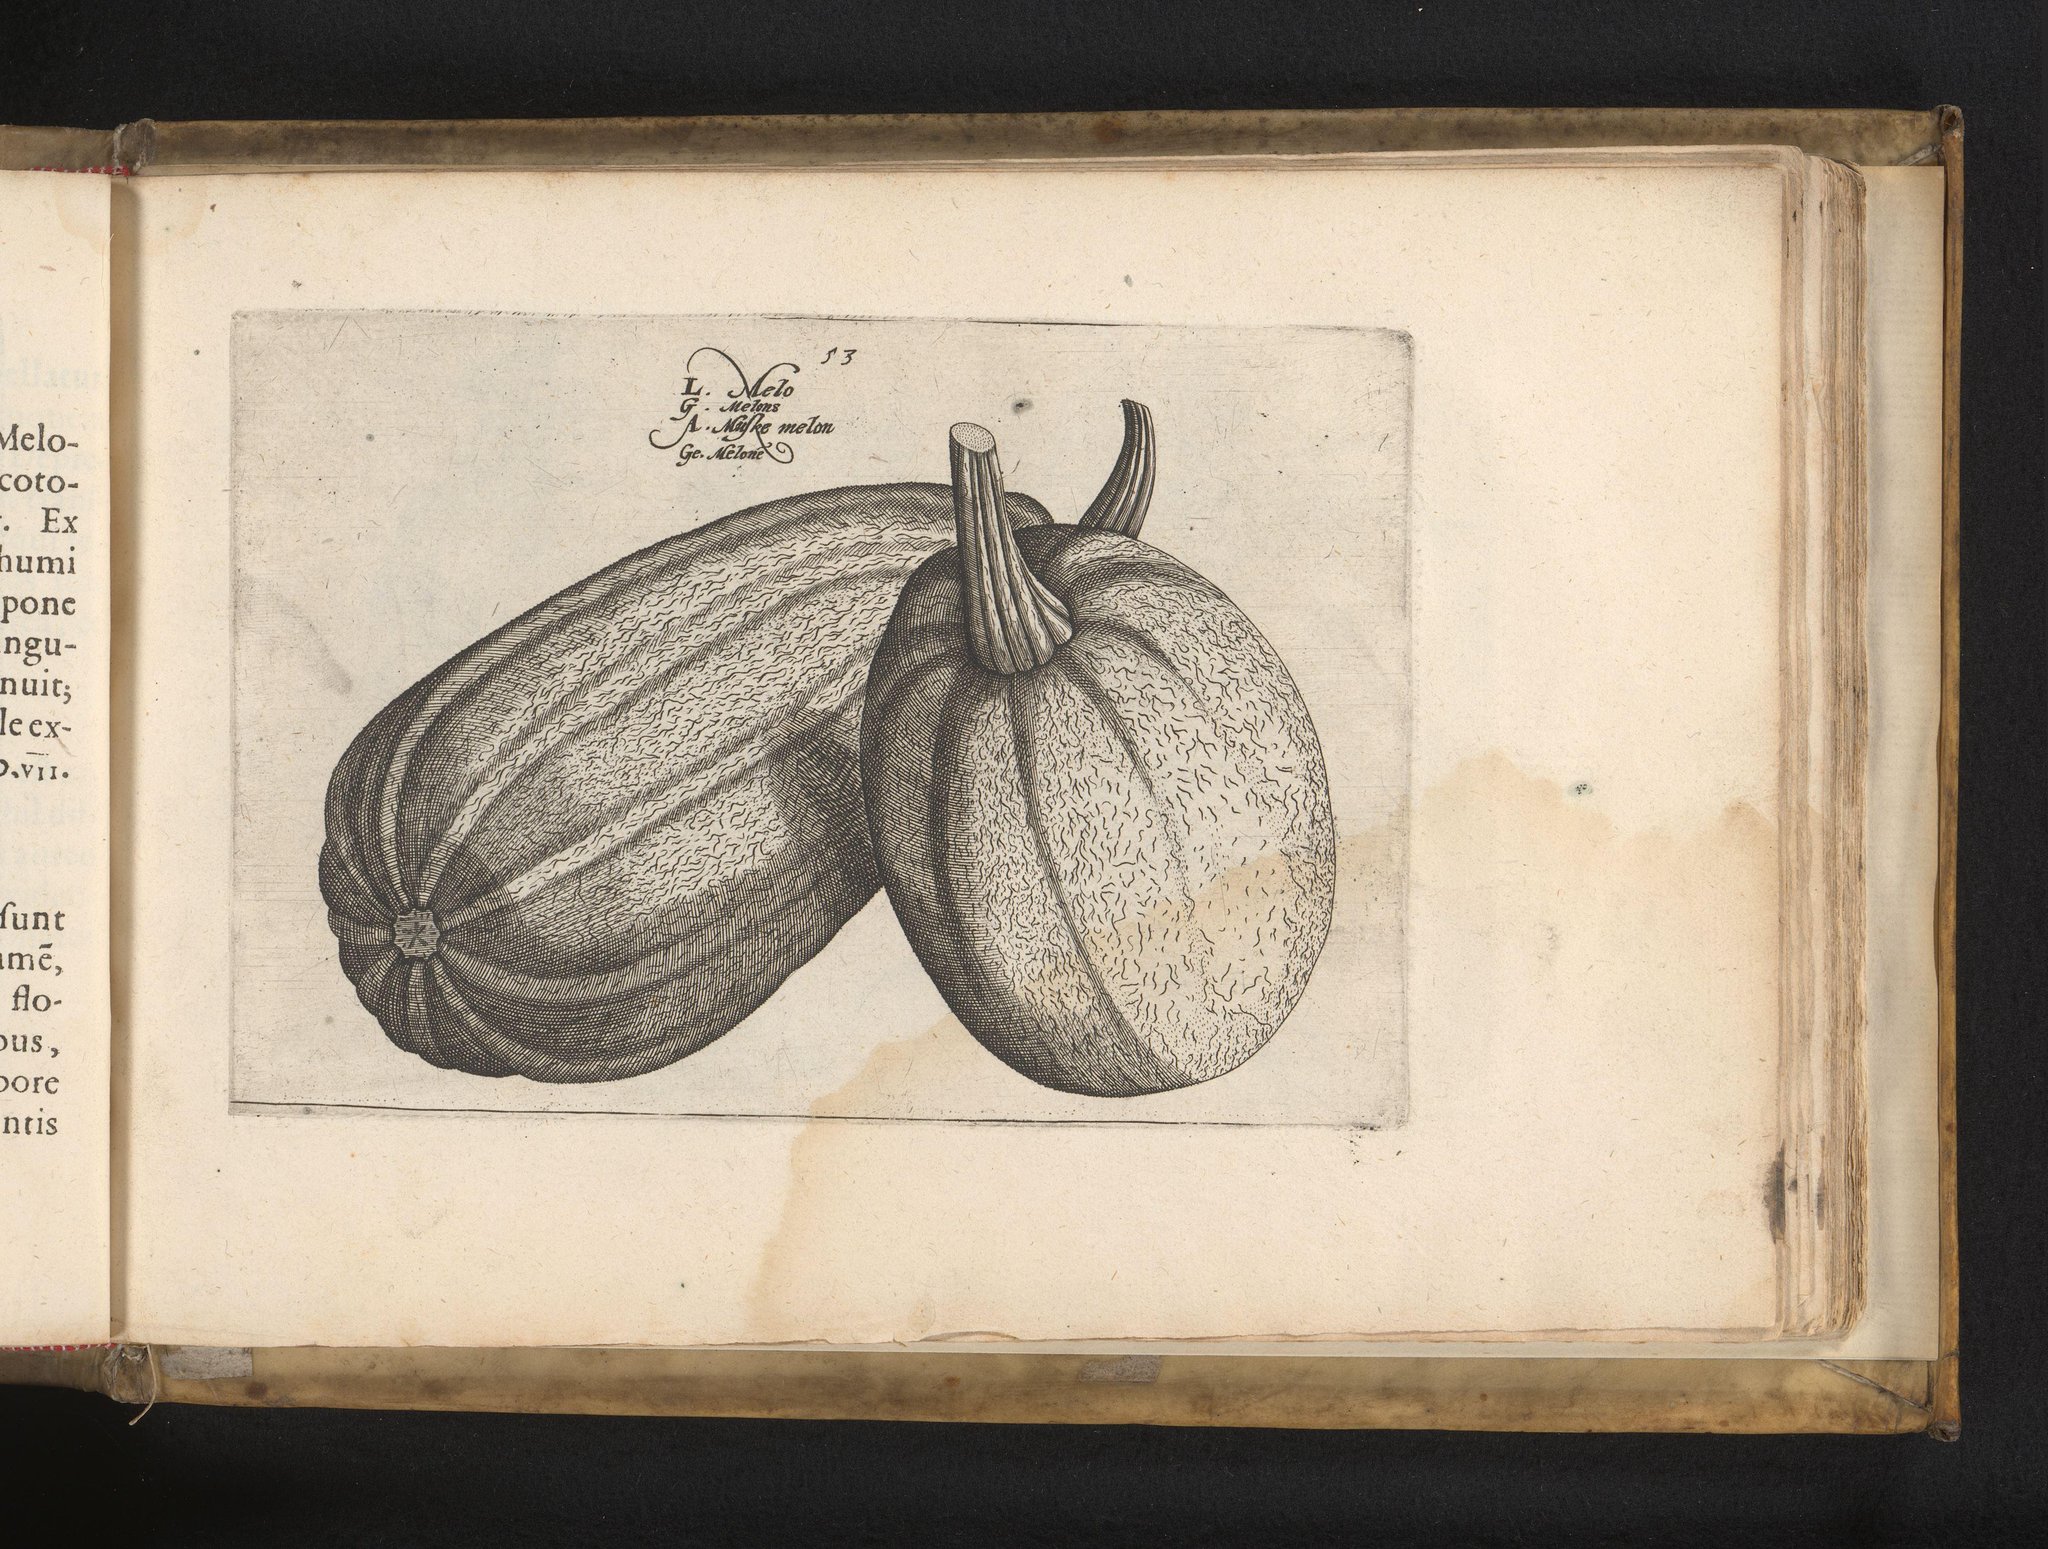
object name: book illustration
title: Bloementuin, het andere deel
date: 1617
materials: paper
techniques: engraving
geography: arnhem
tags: flowers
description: Prent uit: Passe, Crispijn van de (II). Hortus floridus in quo rariorum & minus vulgarium florum icones ad vivam veramque formam. Arnhem: Johannes Janssonius, 1617.